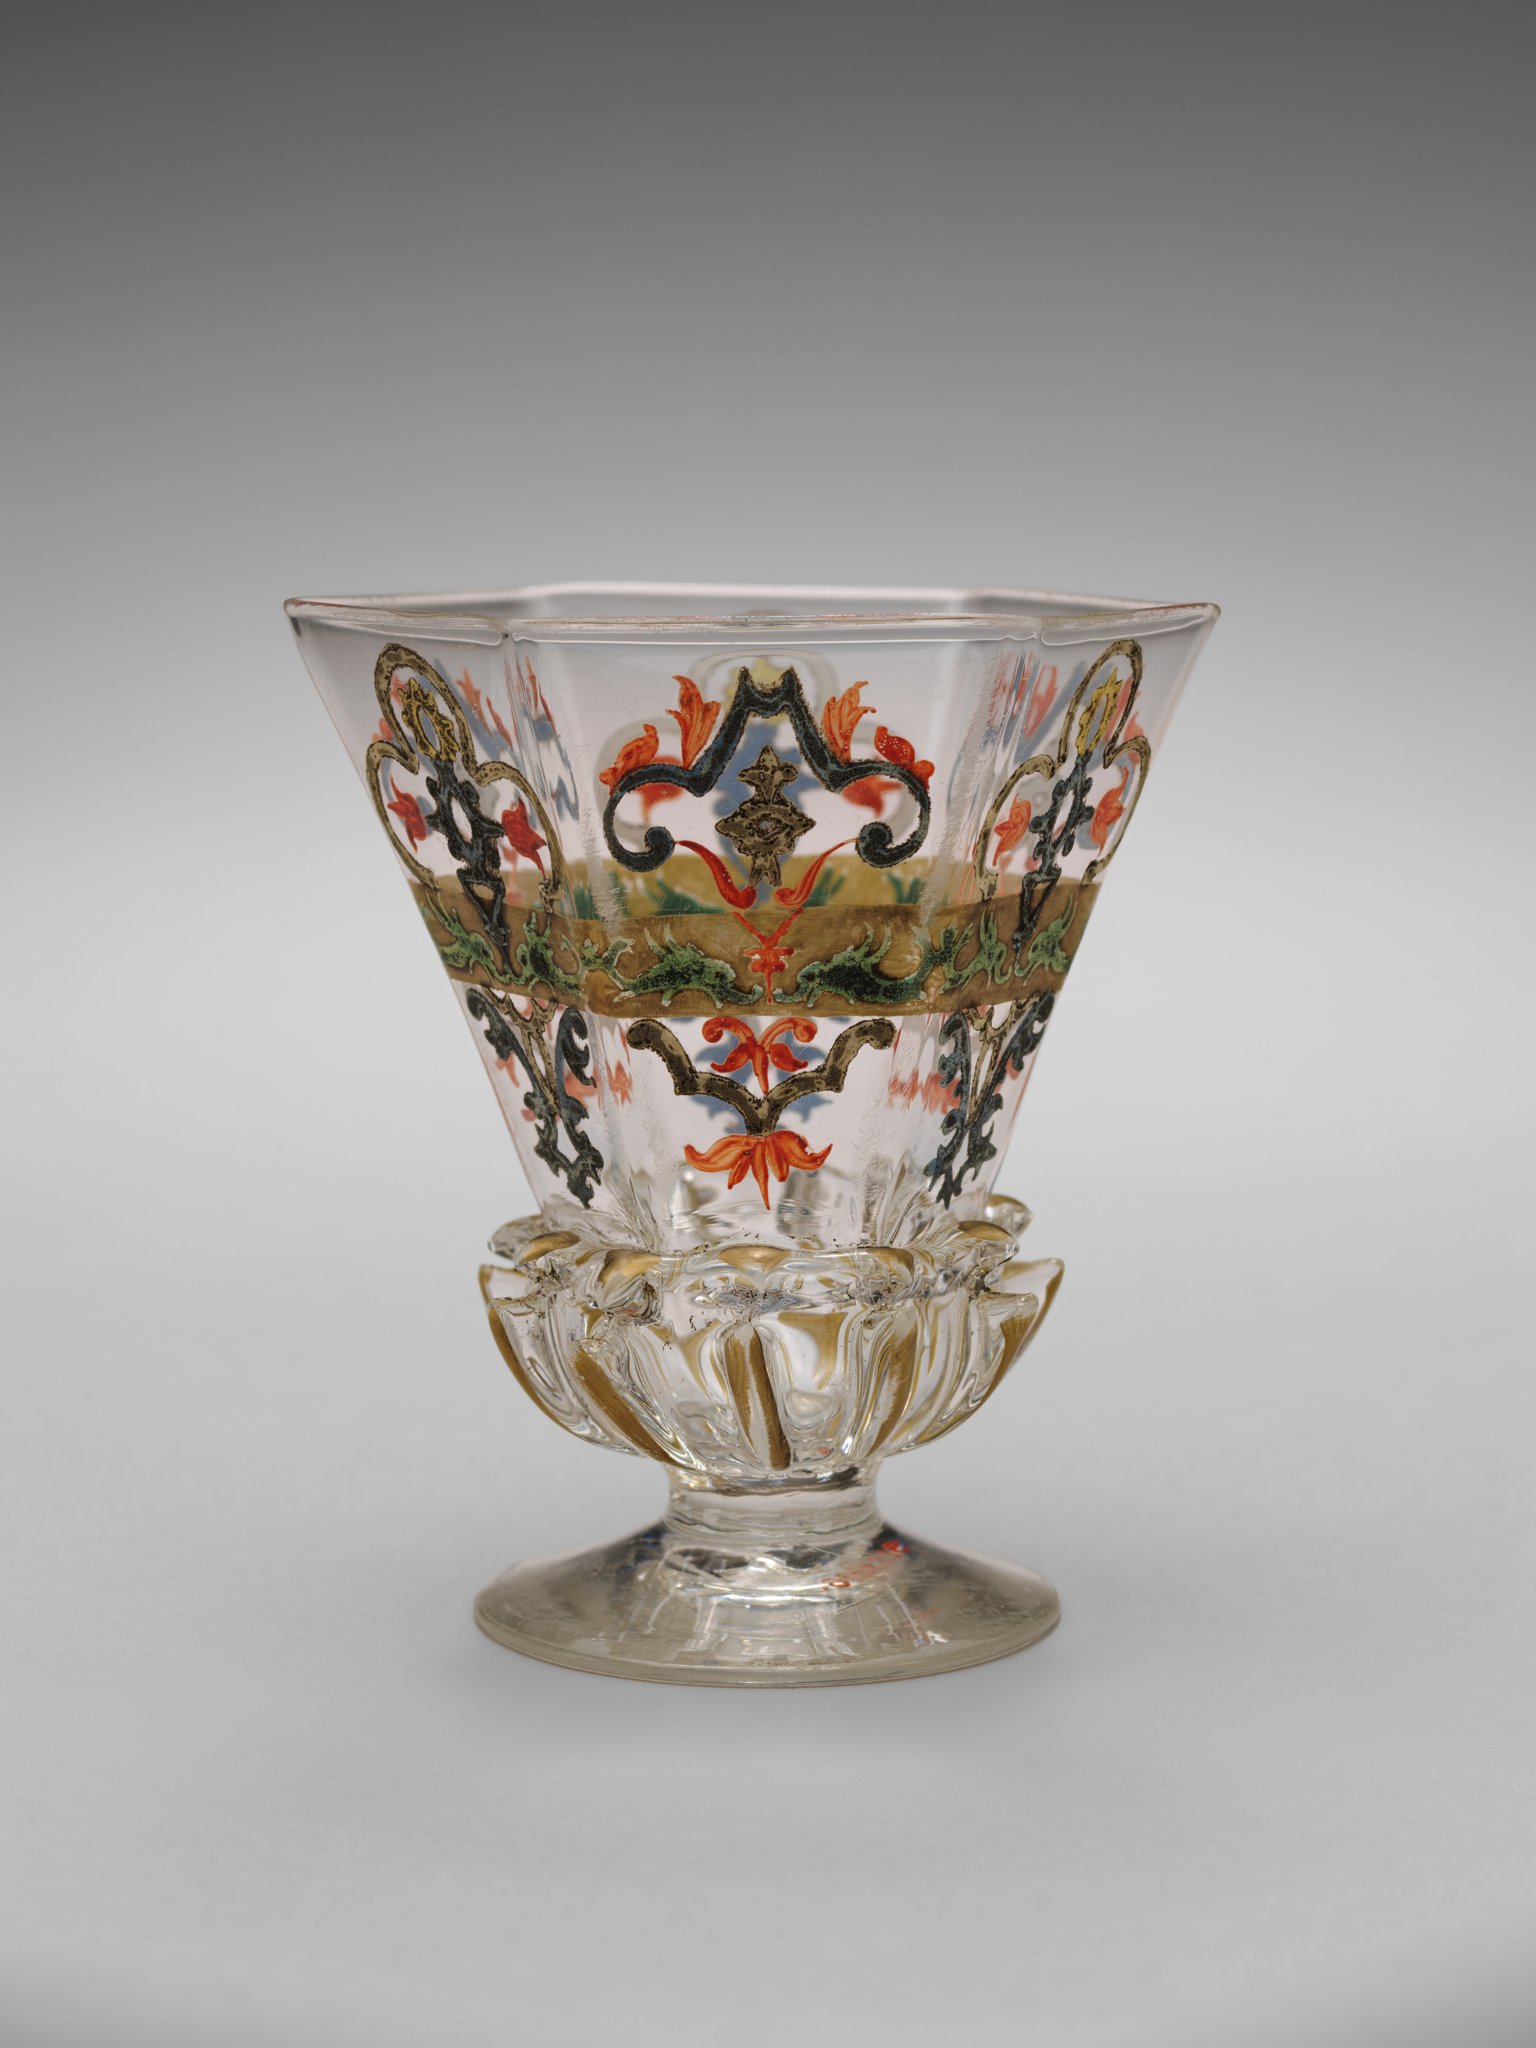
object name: cup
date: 1801-1900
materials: glass